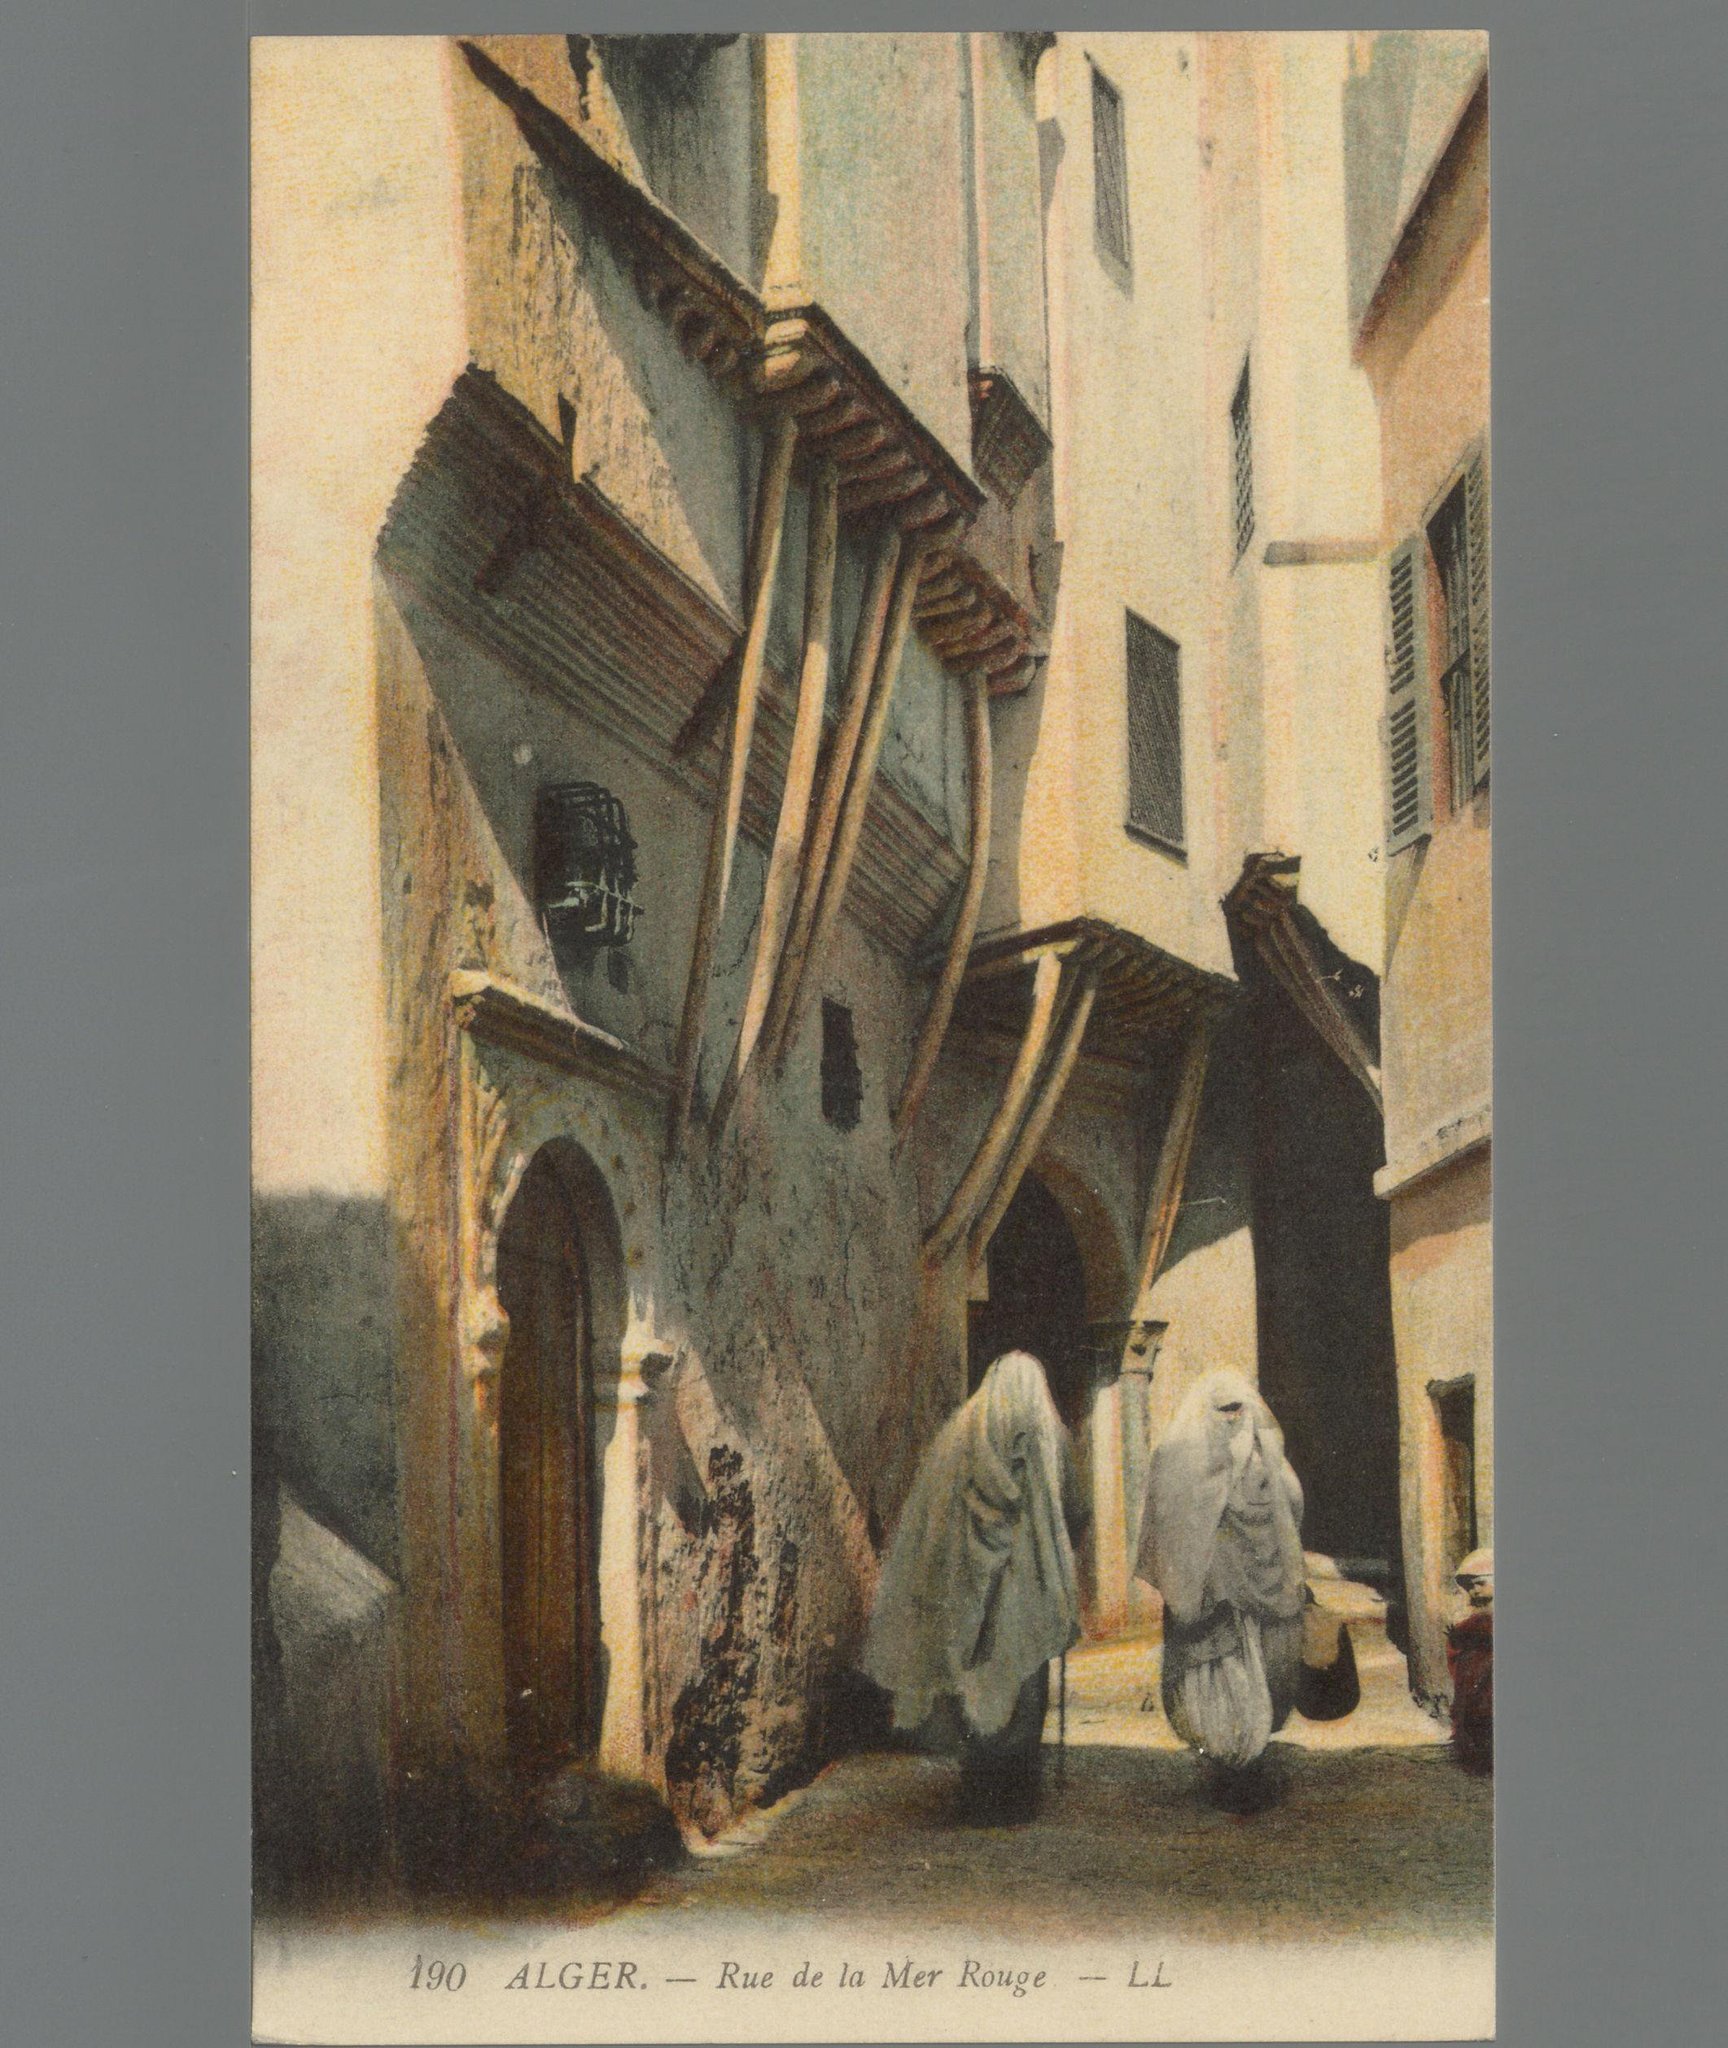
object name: photomechanical print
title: Alger. Rue de la Mer Rouge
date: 1903-1920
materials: cardboard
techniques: photograph, lithograph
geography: paris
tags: urban housing, street (+ city(-scape) with figures, staffage)